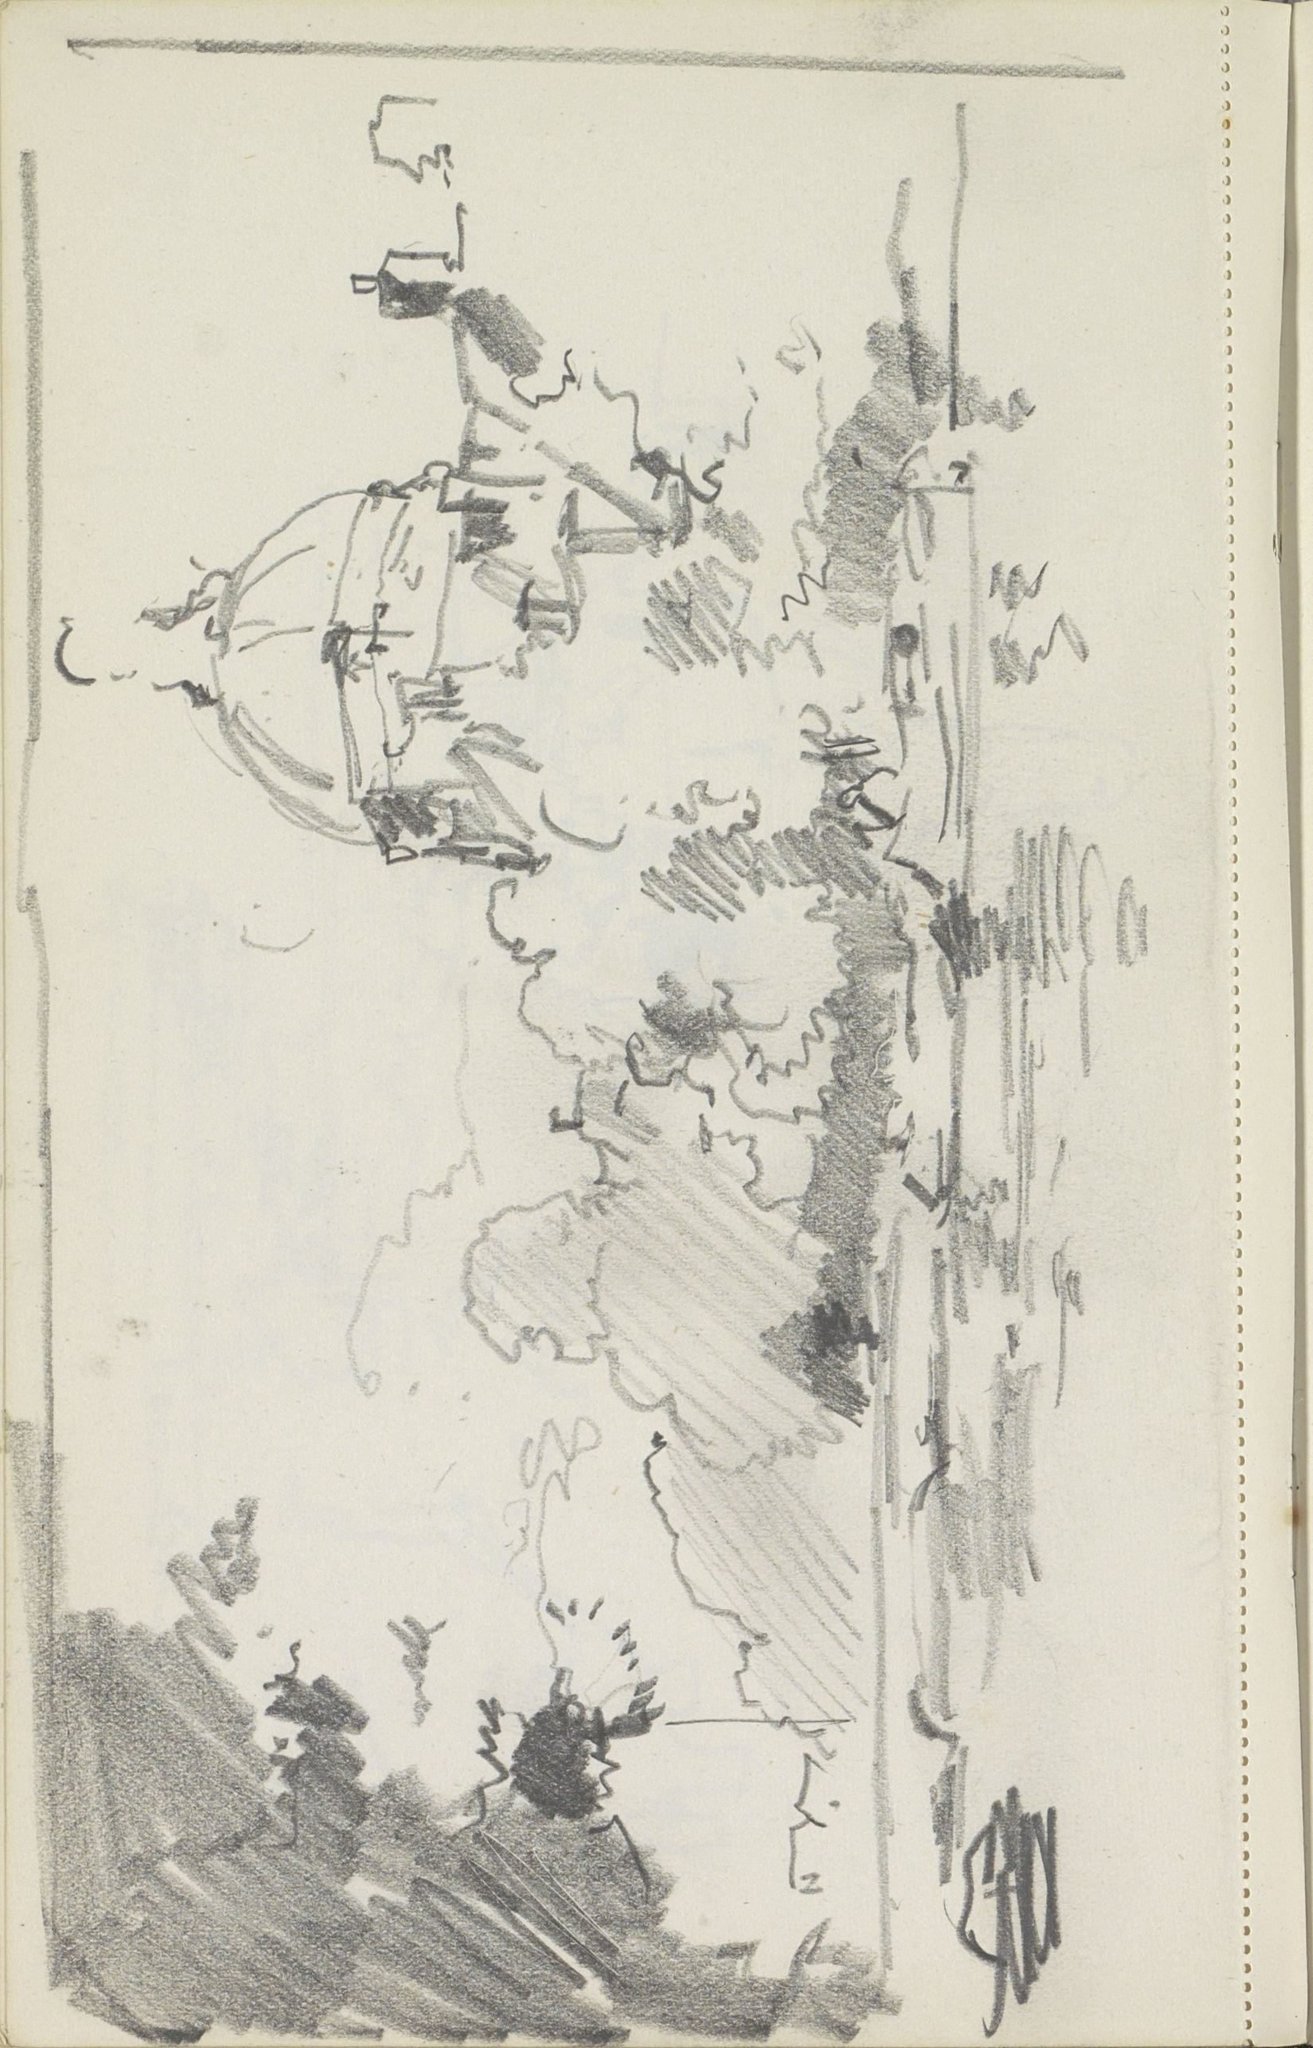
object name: sketchbook leaf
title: Ronde Lutherse Kerk aan het Singel te Amsterdam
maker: cornelis vreedenburgh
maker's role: draughtsman, print maker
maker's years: 1880-1946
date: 1890-1946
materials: paper, pencil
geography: amsterdam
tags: city-view, and landscape with man-made constructions, church (exterior)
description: Blad 41 verso uit een schetsboek met 50 bladen.